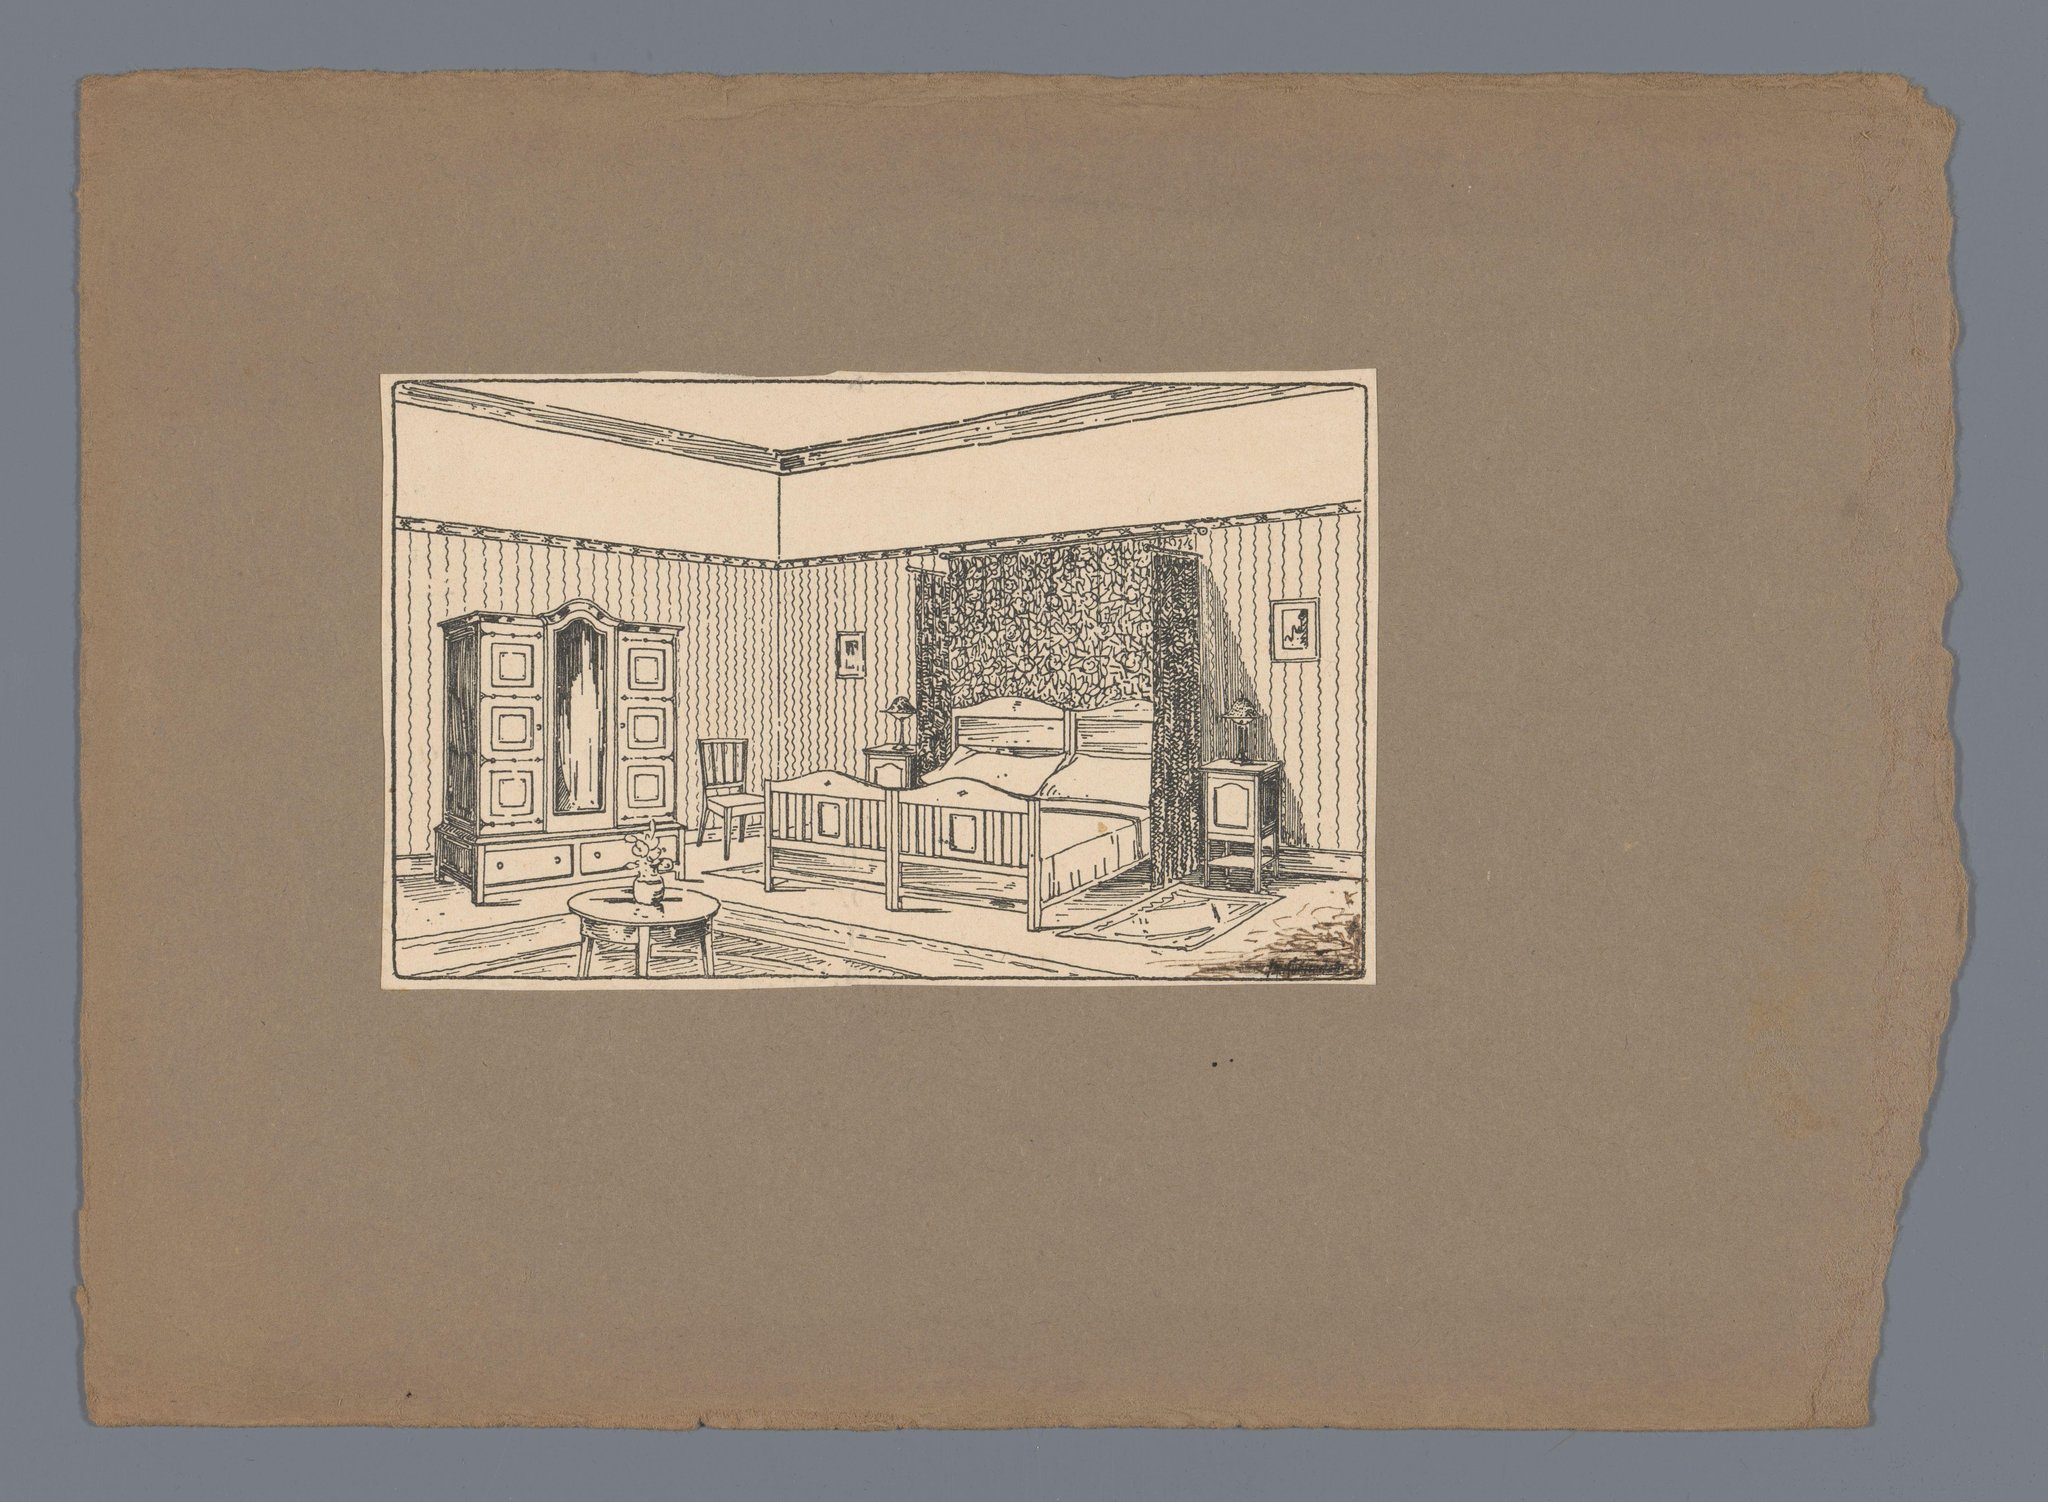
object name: print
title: Slaapkamer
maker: Anonymous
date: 1875-1900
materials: paper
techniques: lithograph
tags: bed, other rooms